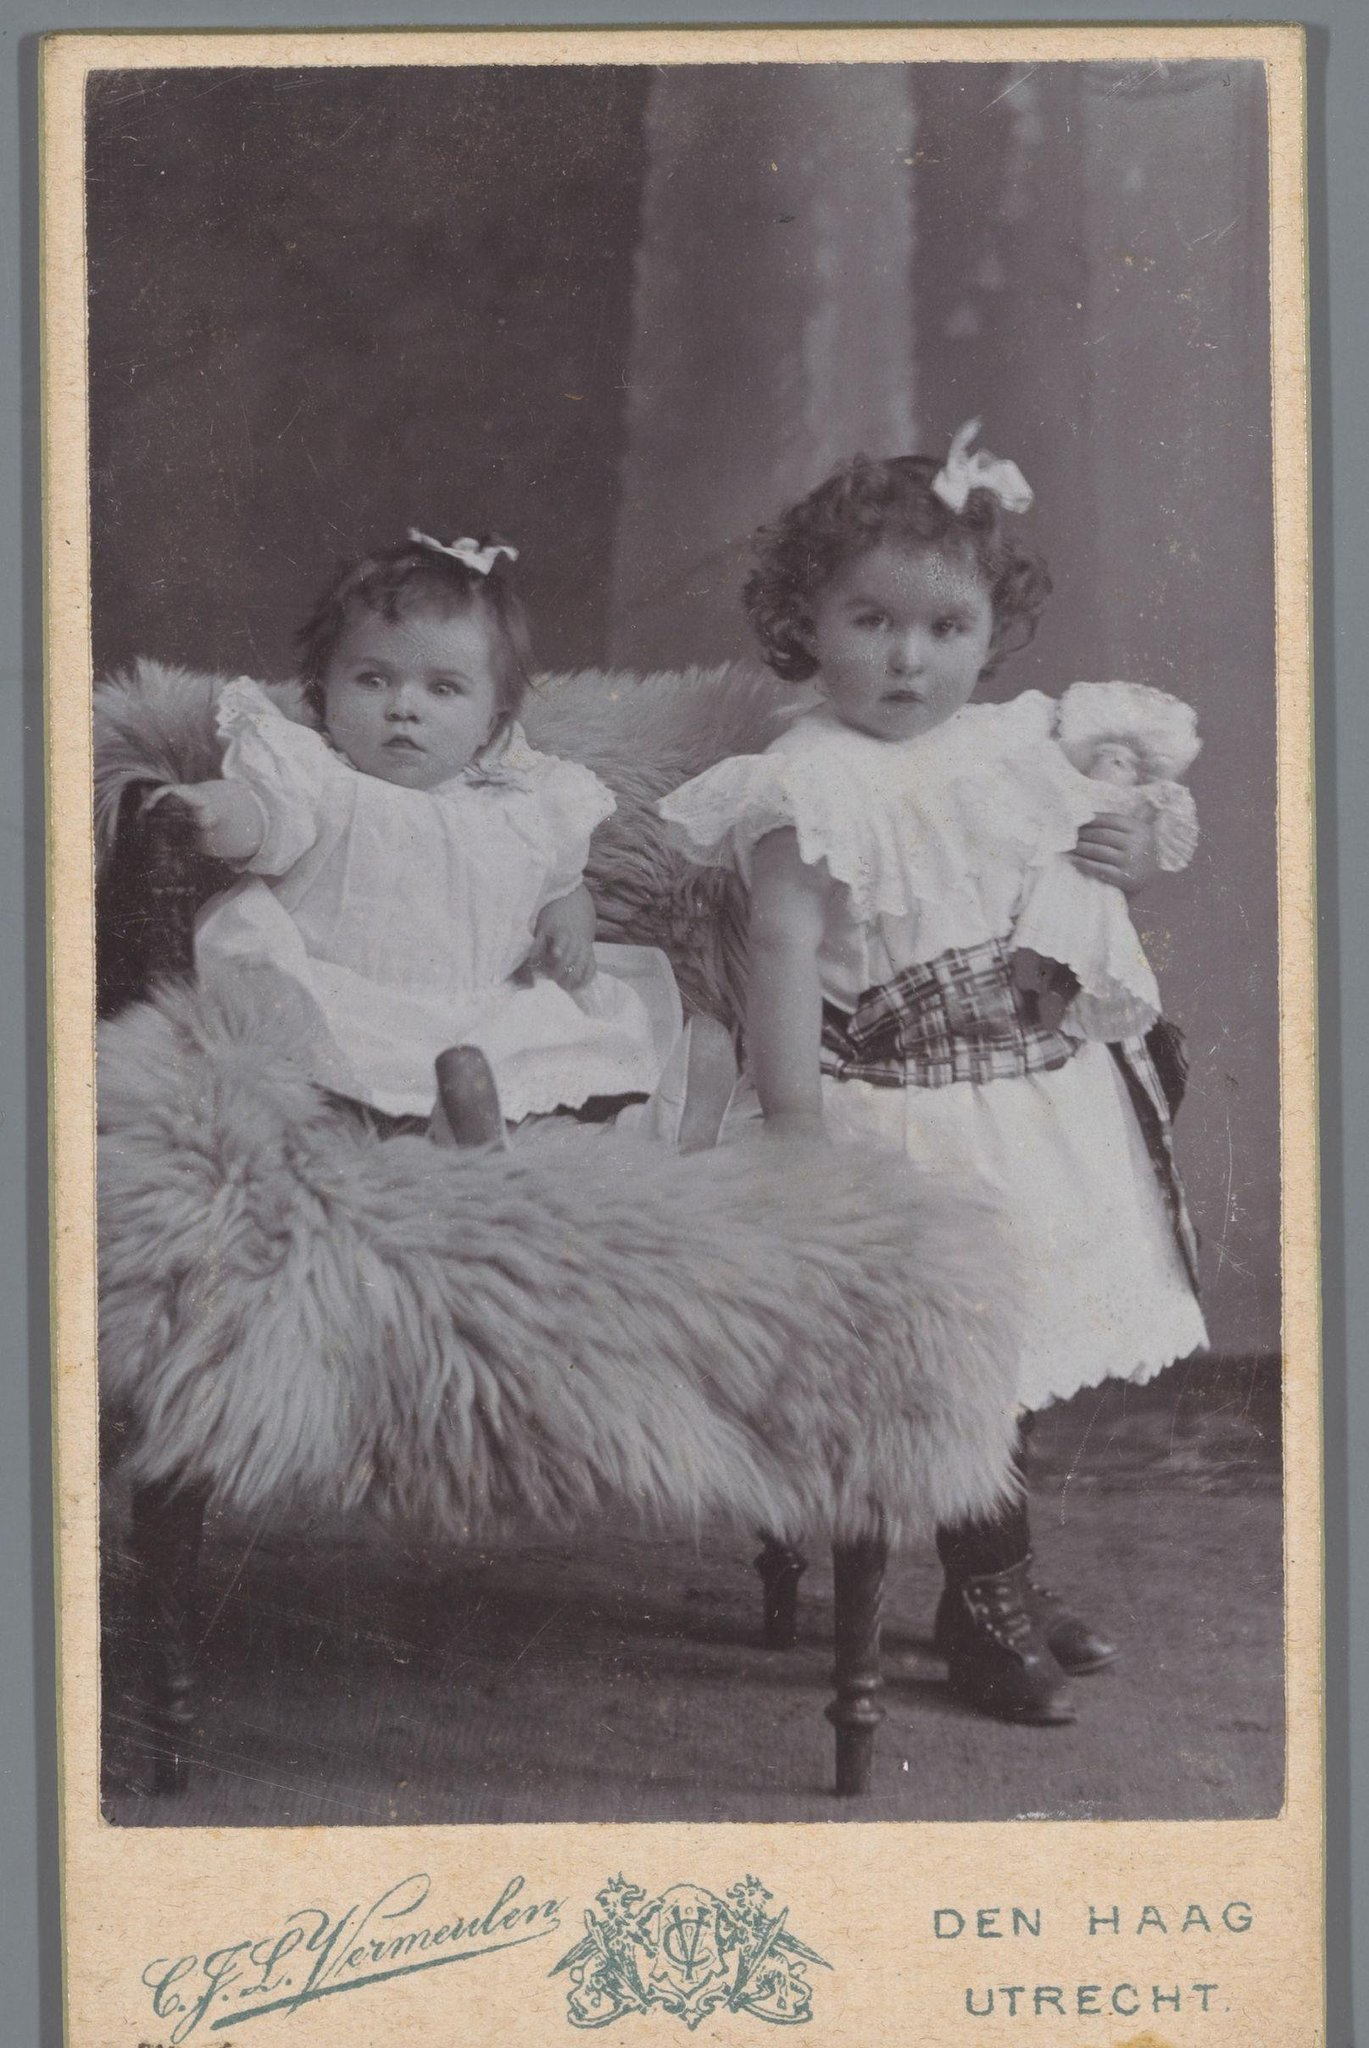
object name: carte de visite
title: Portret van twee onbekende meisjes bij een stoel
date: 1890-1915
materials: cardboard, photographic support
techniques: collodion silver print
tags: historical persons, girl (child between toddler and youth) (+ two persons), chair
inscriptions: inscription: ‘CV/ C. J. L. Vermeulen/ Den Haag/ Toussaintkade 11./ Intercommunal Telephoon: 774./ UTRECHT/ Nieuwe gracht 50./ Telephoon No 750./ BLOCK & Co. BERLIN, S.W.’